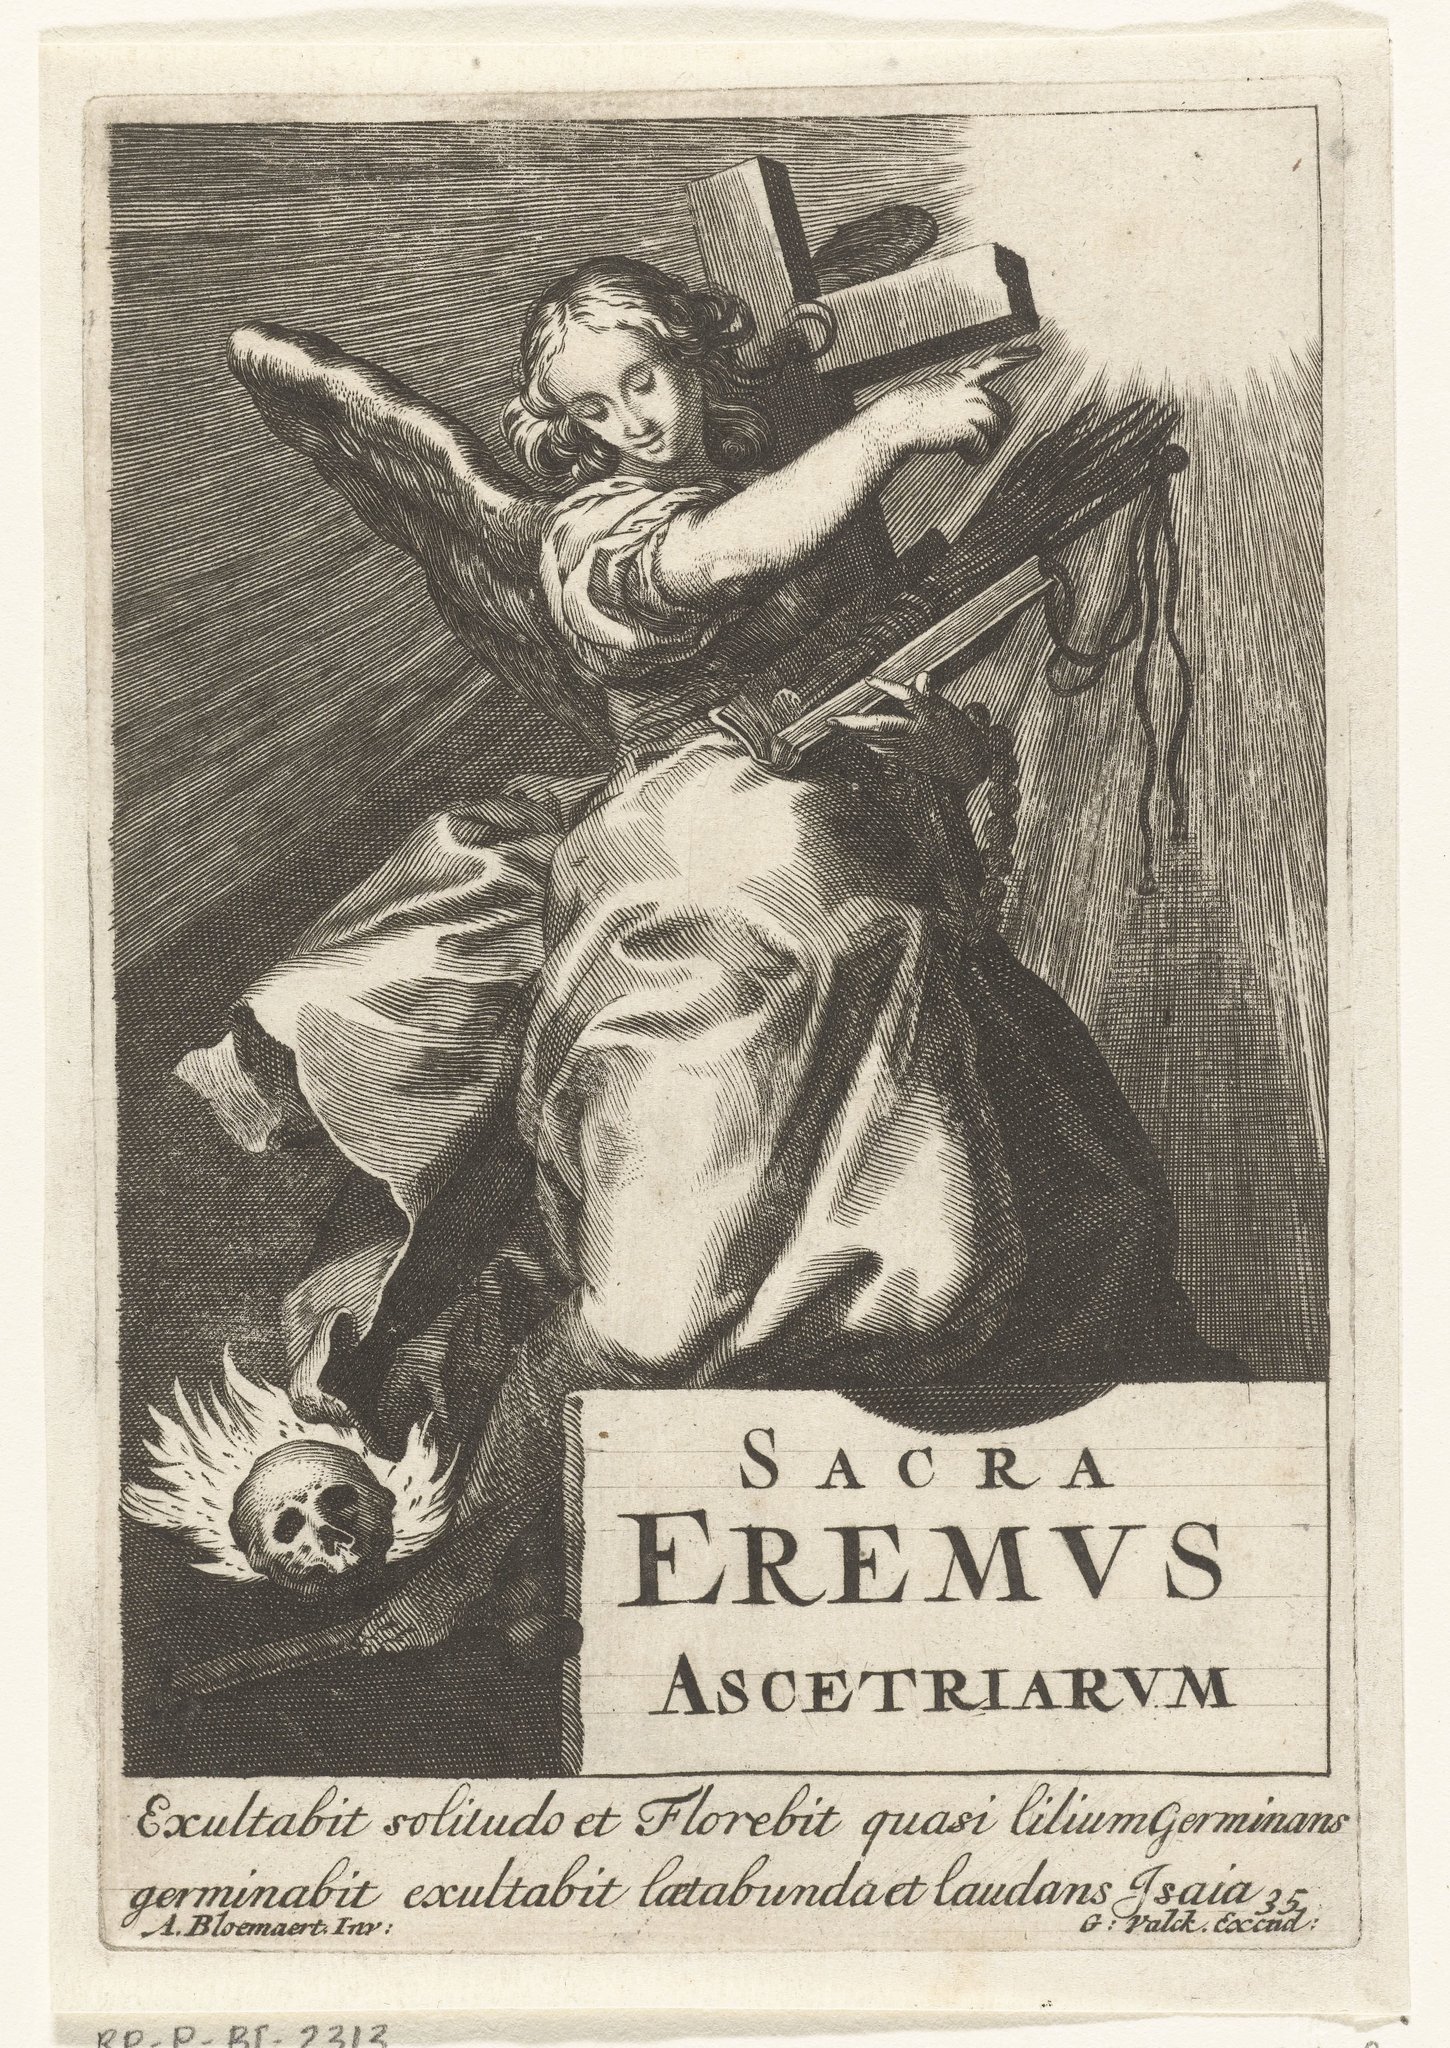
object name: print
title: Kluizenaressen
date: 1590-1662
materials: paper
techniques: engraving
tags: ascetic life and practice, angels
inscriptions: collector's mark: Lugt 2228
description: Kopie in spiegelbeeld naar prent van Boëtius Adamsz. Bolswert. Prent naar titelpagina voor serie van vijfentwintig kluizenaressen met titel Sacra Eremus Ascetriarum.